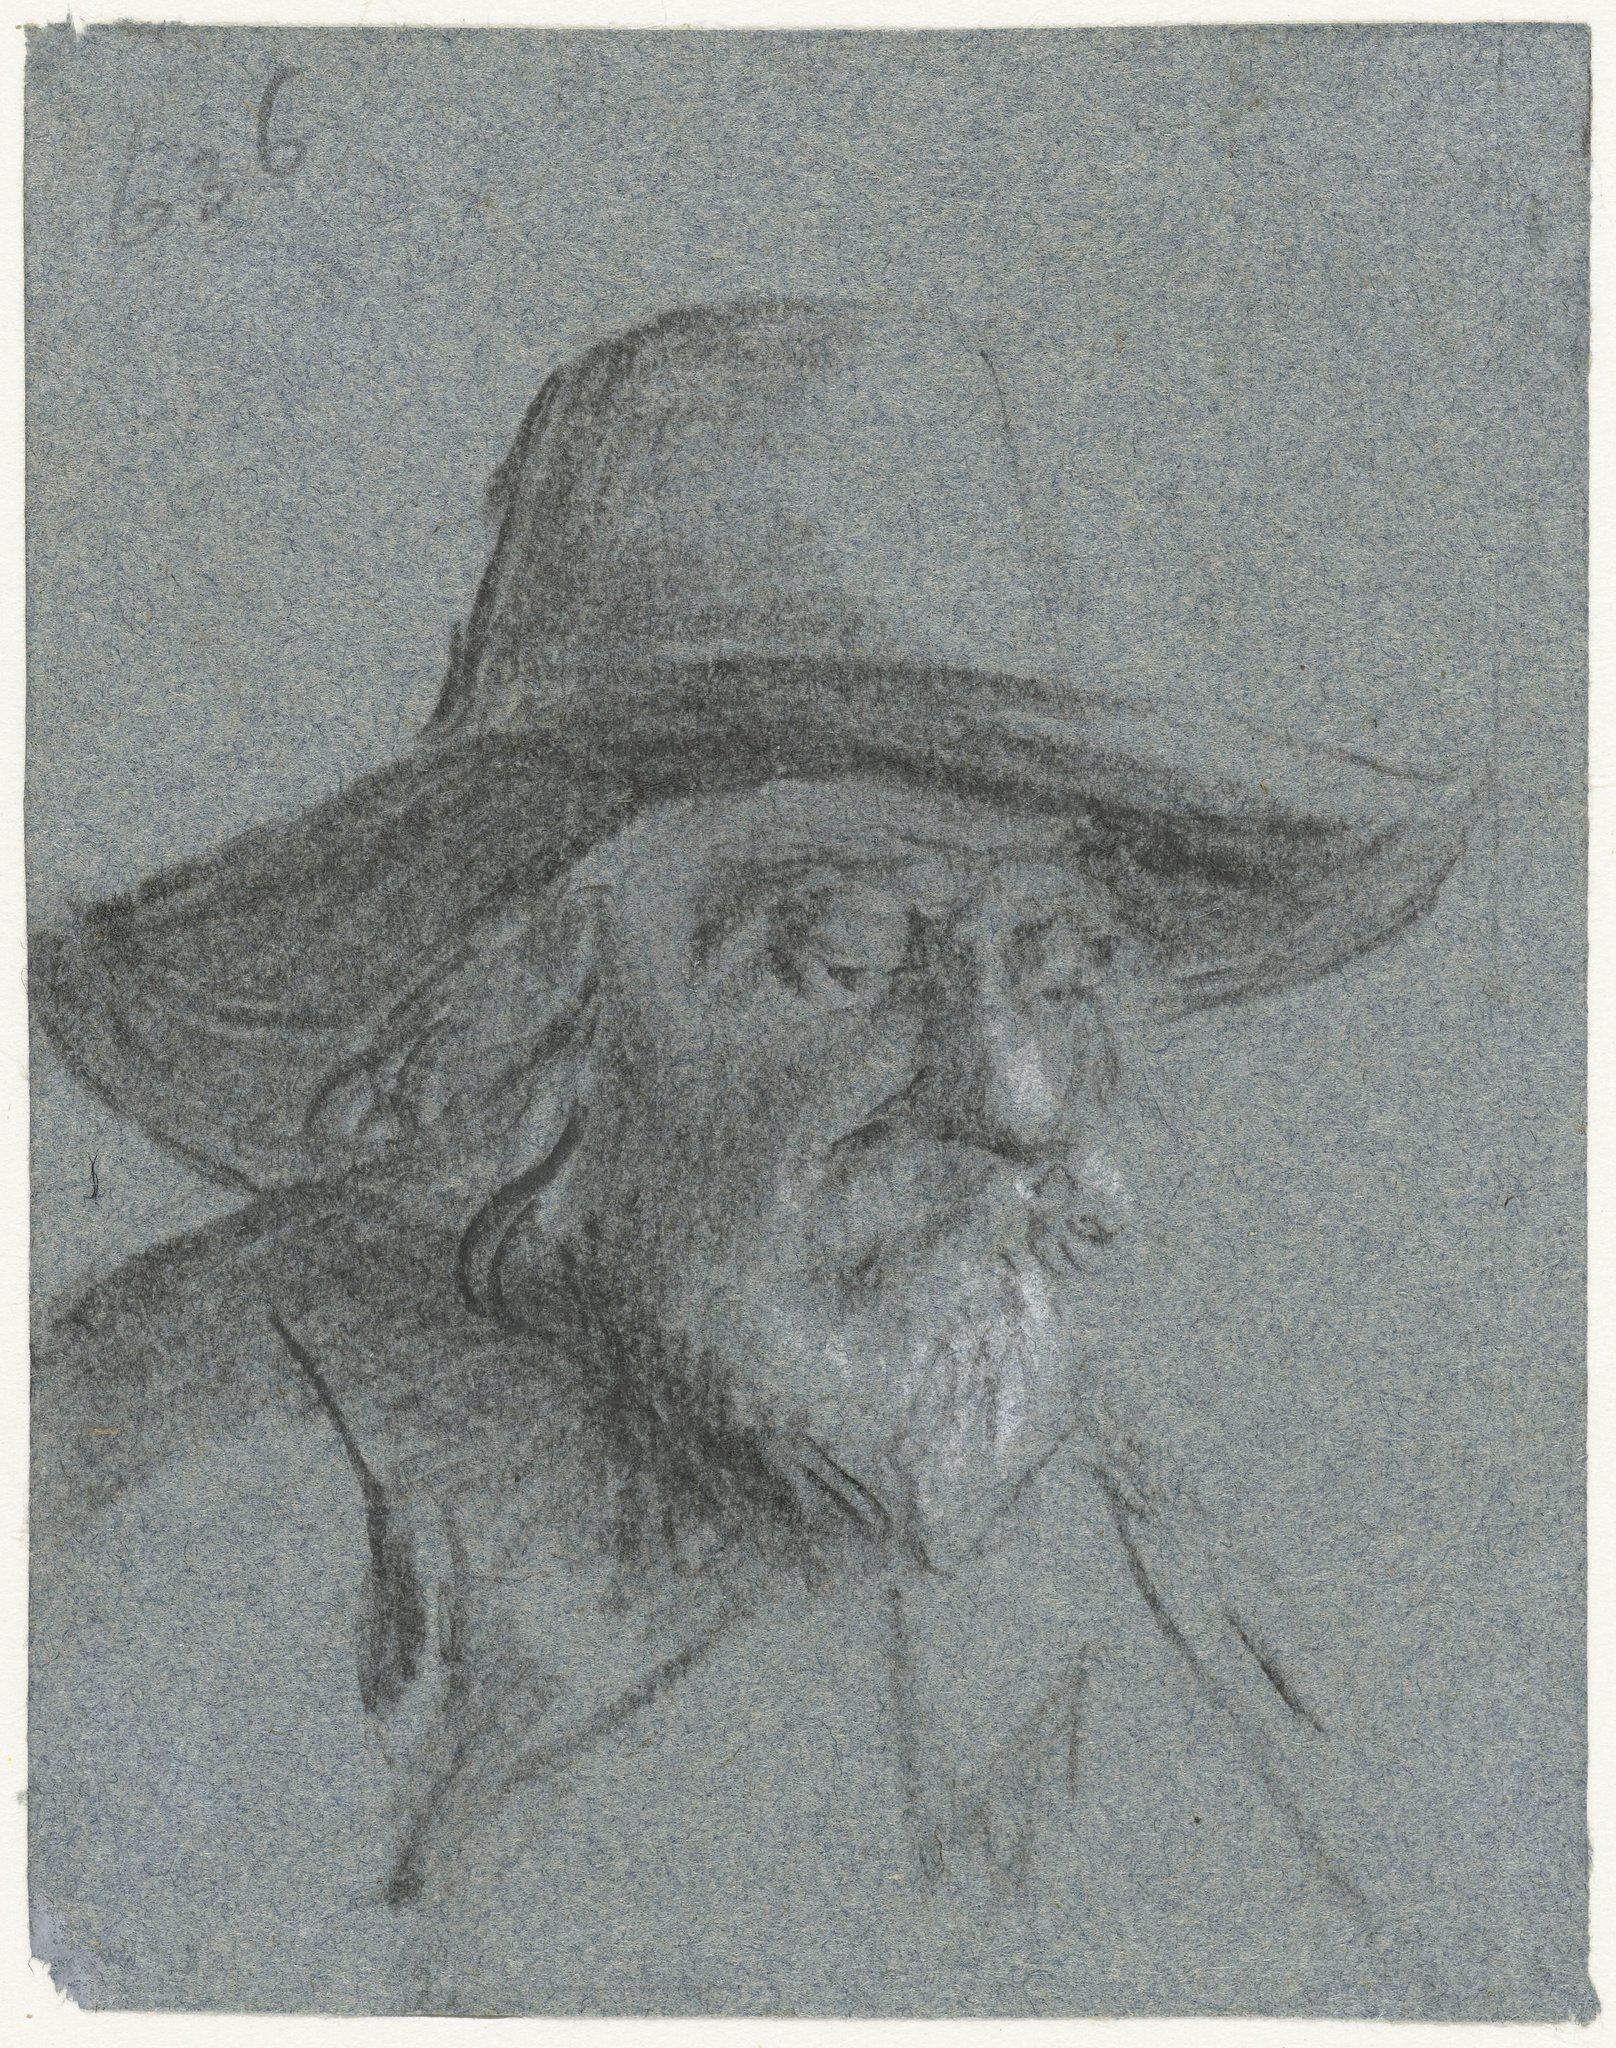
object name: drawing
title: Portret van Gerard ter Borch de Oude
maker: moses ter borch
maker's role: draughtsman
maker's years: 1645-1667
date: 1660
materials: chalk, paper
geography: zwolle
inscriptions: number: ‘29’